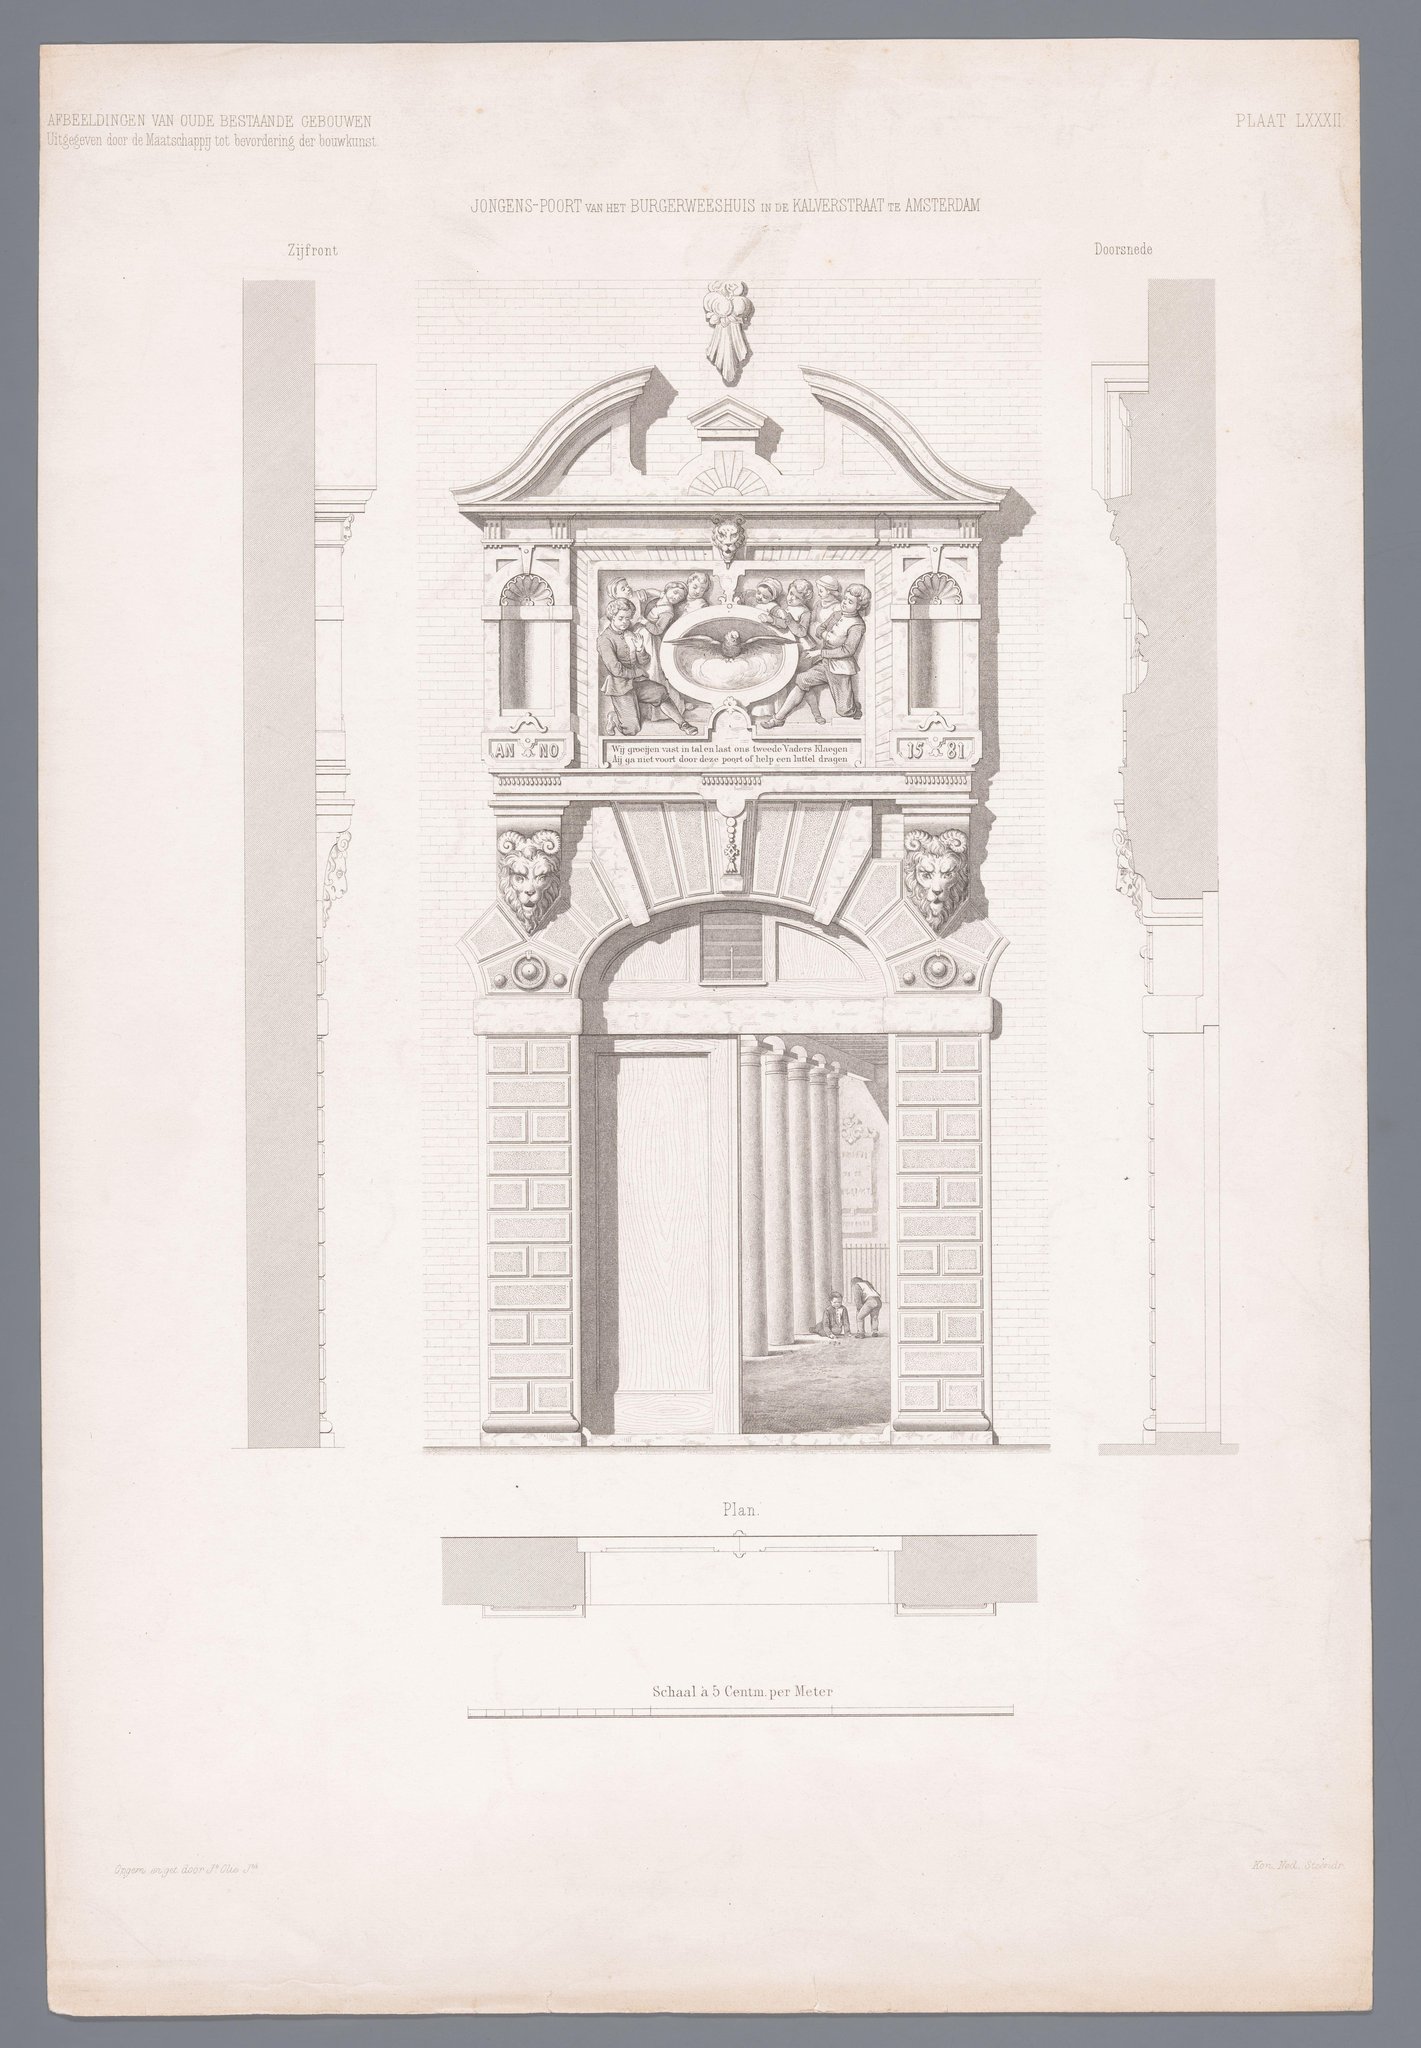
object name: book illustration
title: Jongens-poort van het burgerweeshuis in de Kalverstraat te Amsterdam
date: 1880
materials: paper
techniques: lithograph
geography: amsterdam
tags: orphanage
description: Prent uit: Afbeeldingen van oude bestaande gebouwen. Uitgegeven door de maatschappij tot bevordering der bouwkunst / Vieux batimens existants (...). Amsterdam: L. van Bakkenes & Co., 1880.